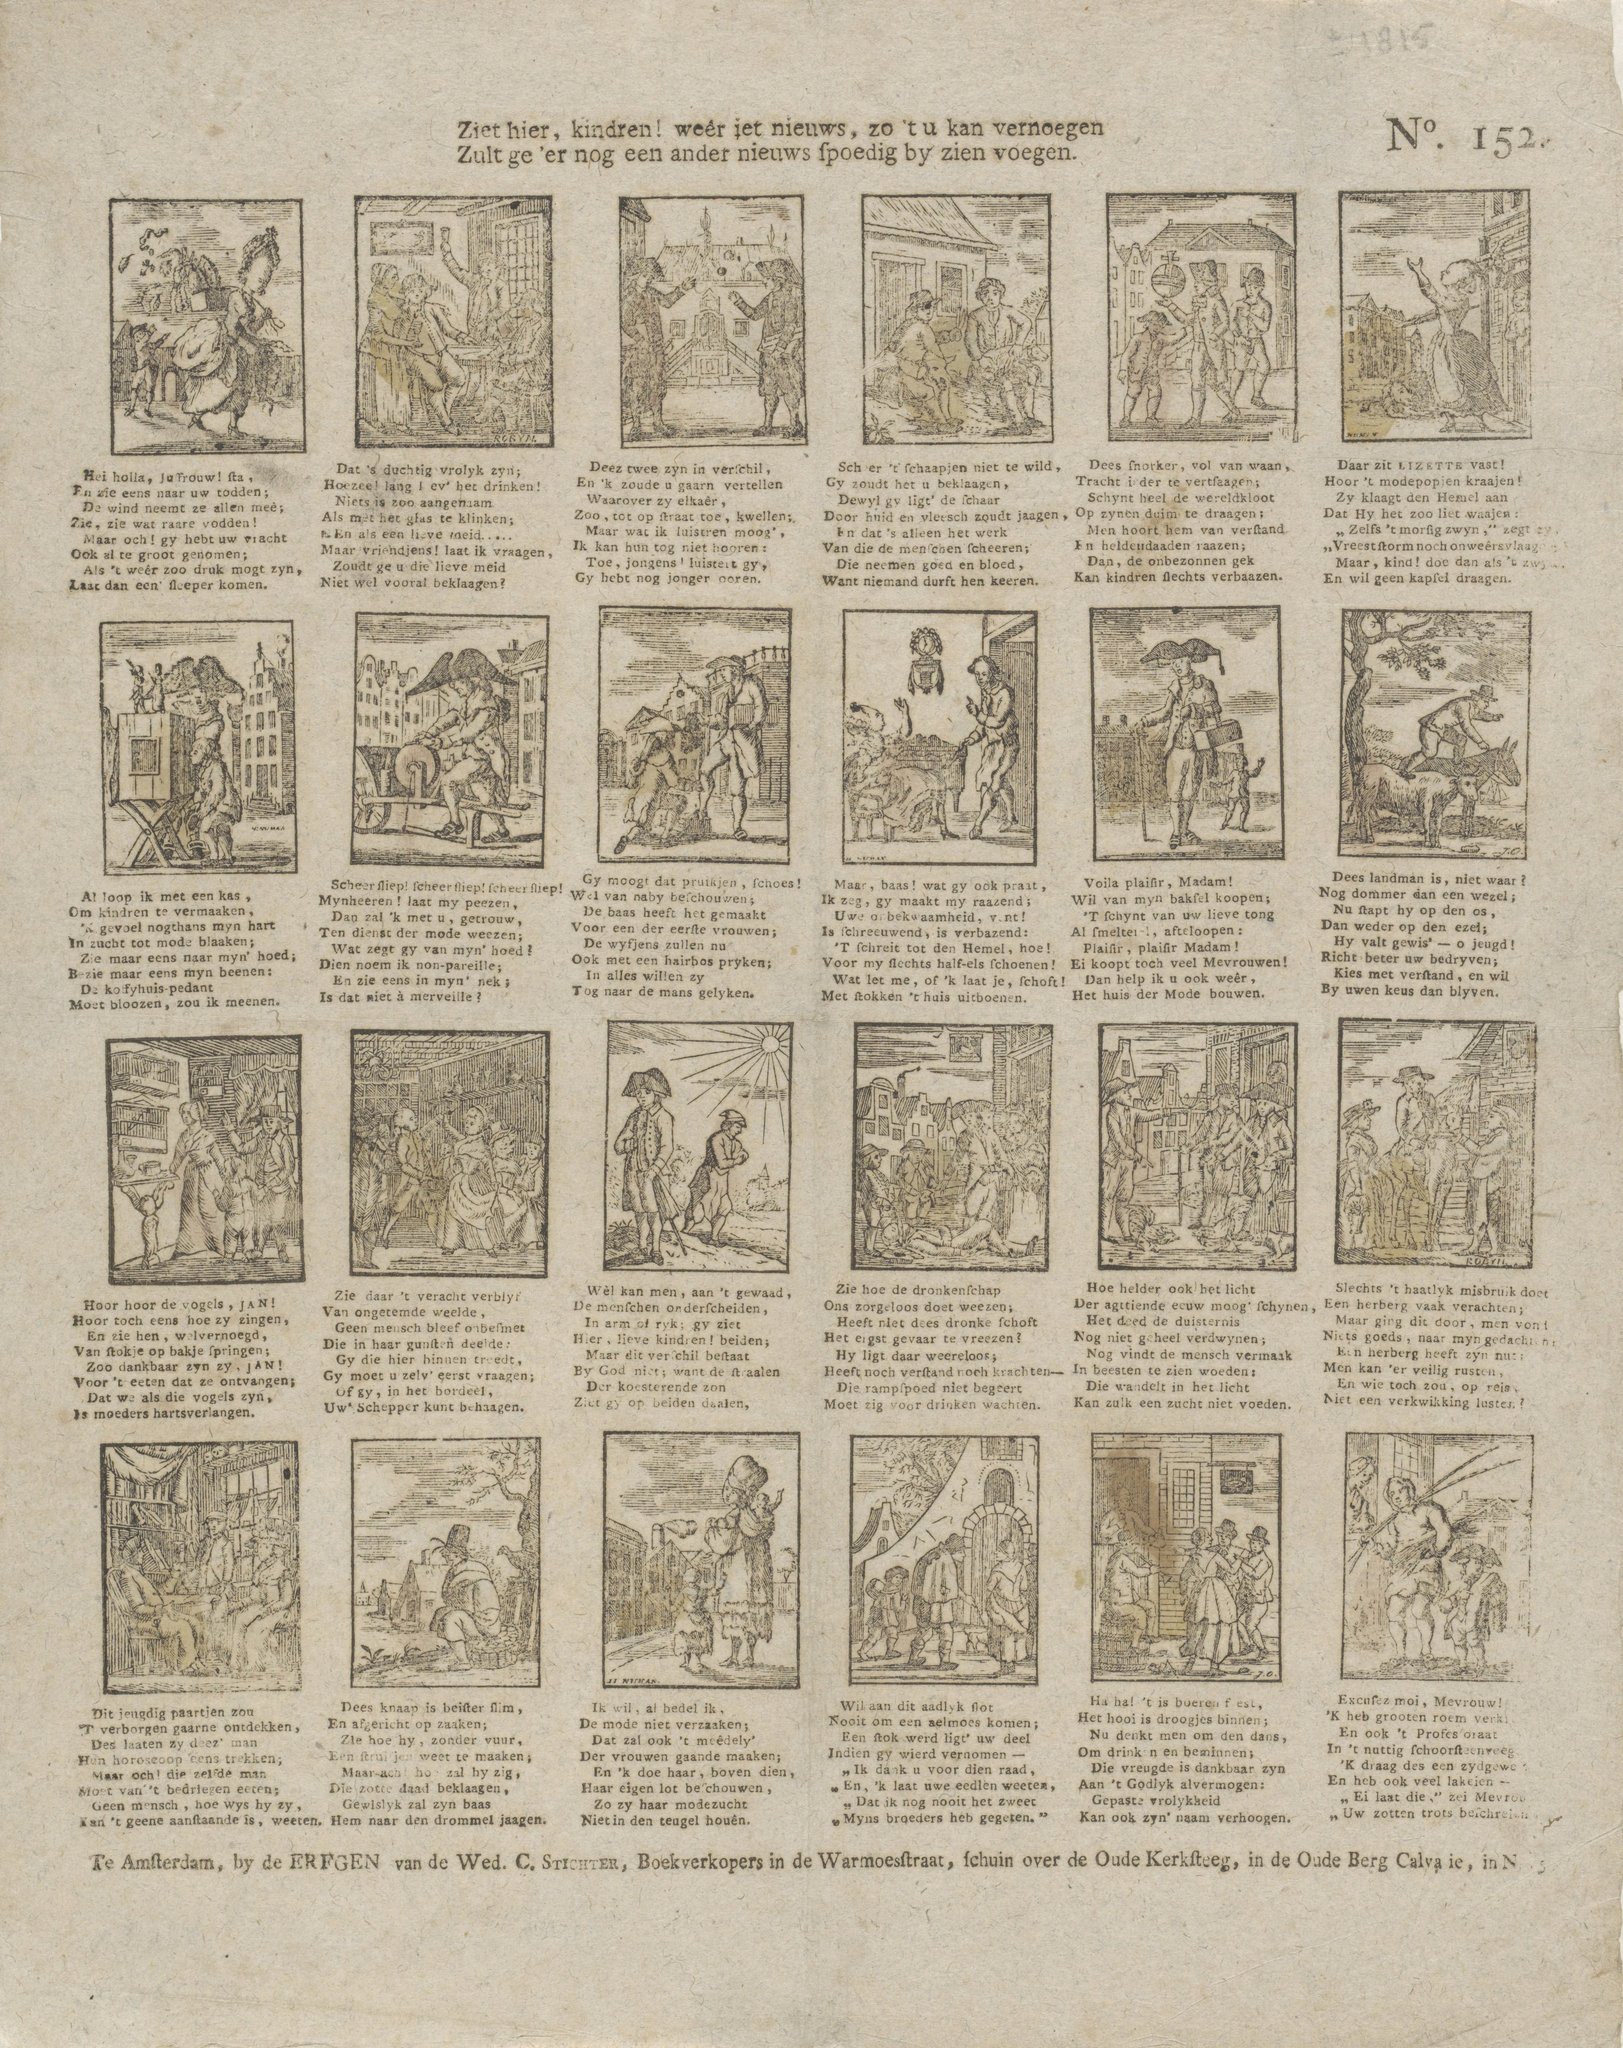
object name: print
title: Ziet hier, kindren! weêr iet nieuws, zo 't u kan vernoegen / Zult ge 'er nog een ander nieuws spoedig by zien voegen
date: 1715-1813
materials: paper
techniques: colour, letterpress printing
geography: amsterdam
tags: musician at work, human types, imprisonment, adultery, defecation, milkmaid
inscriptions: collector's mark: Lugt 2228, collector's mark: Lugt 2760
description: Blad met 24 voorstellingen van verschillende figuren, beroepen en bezigheden. Onder elke afbeelding een achtregelig vers. Genummerd rechtsboven: No. 152.